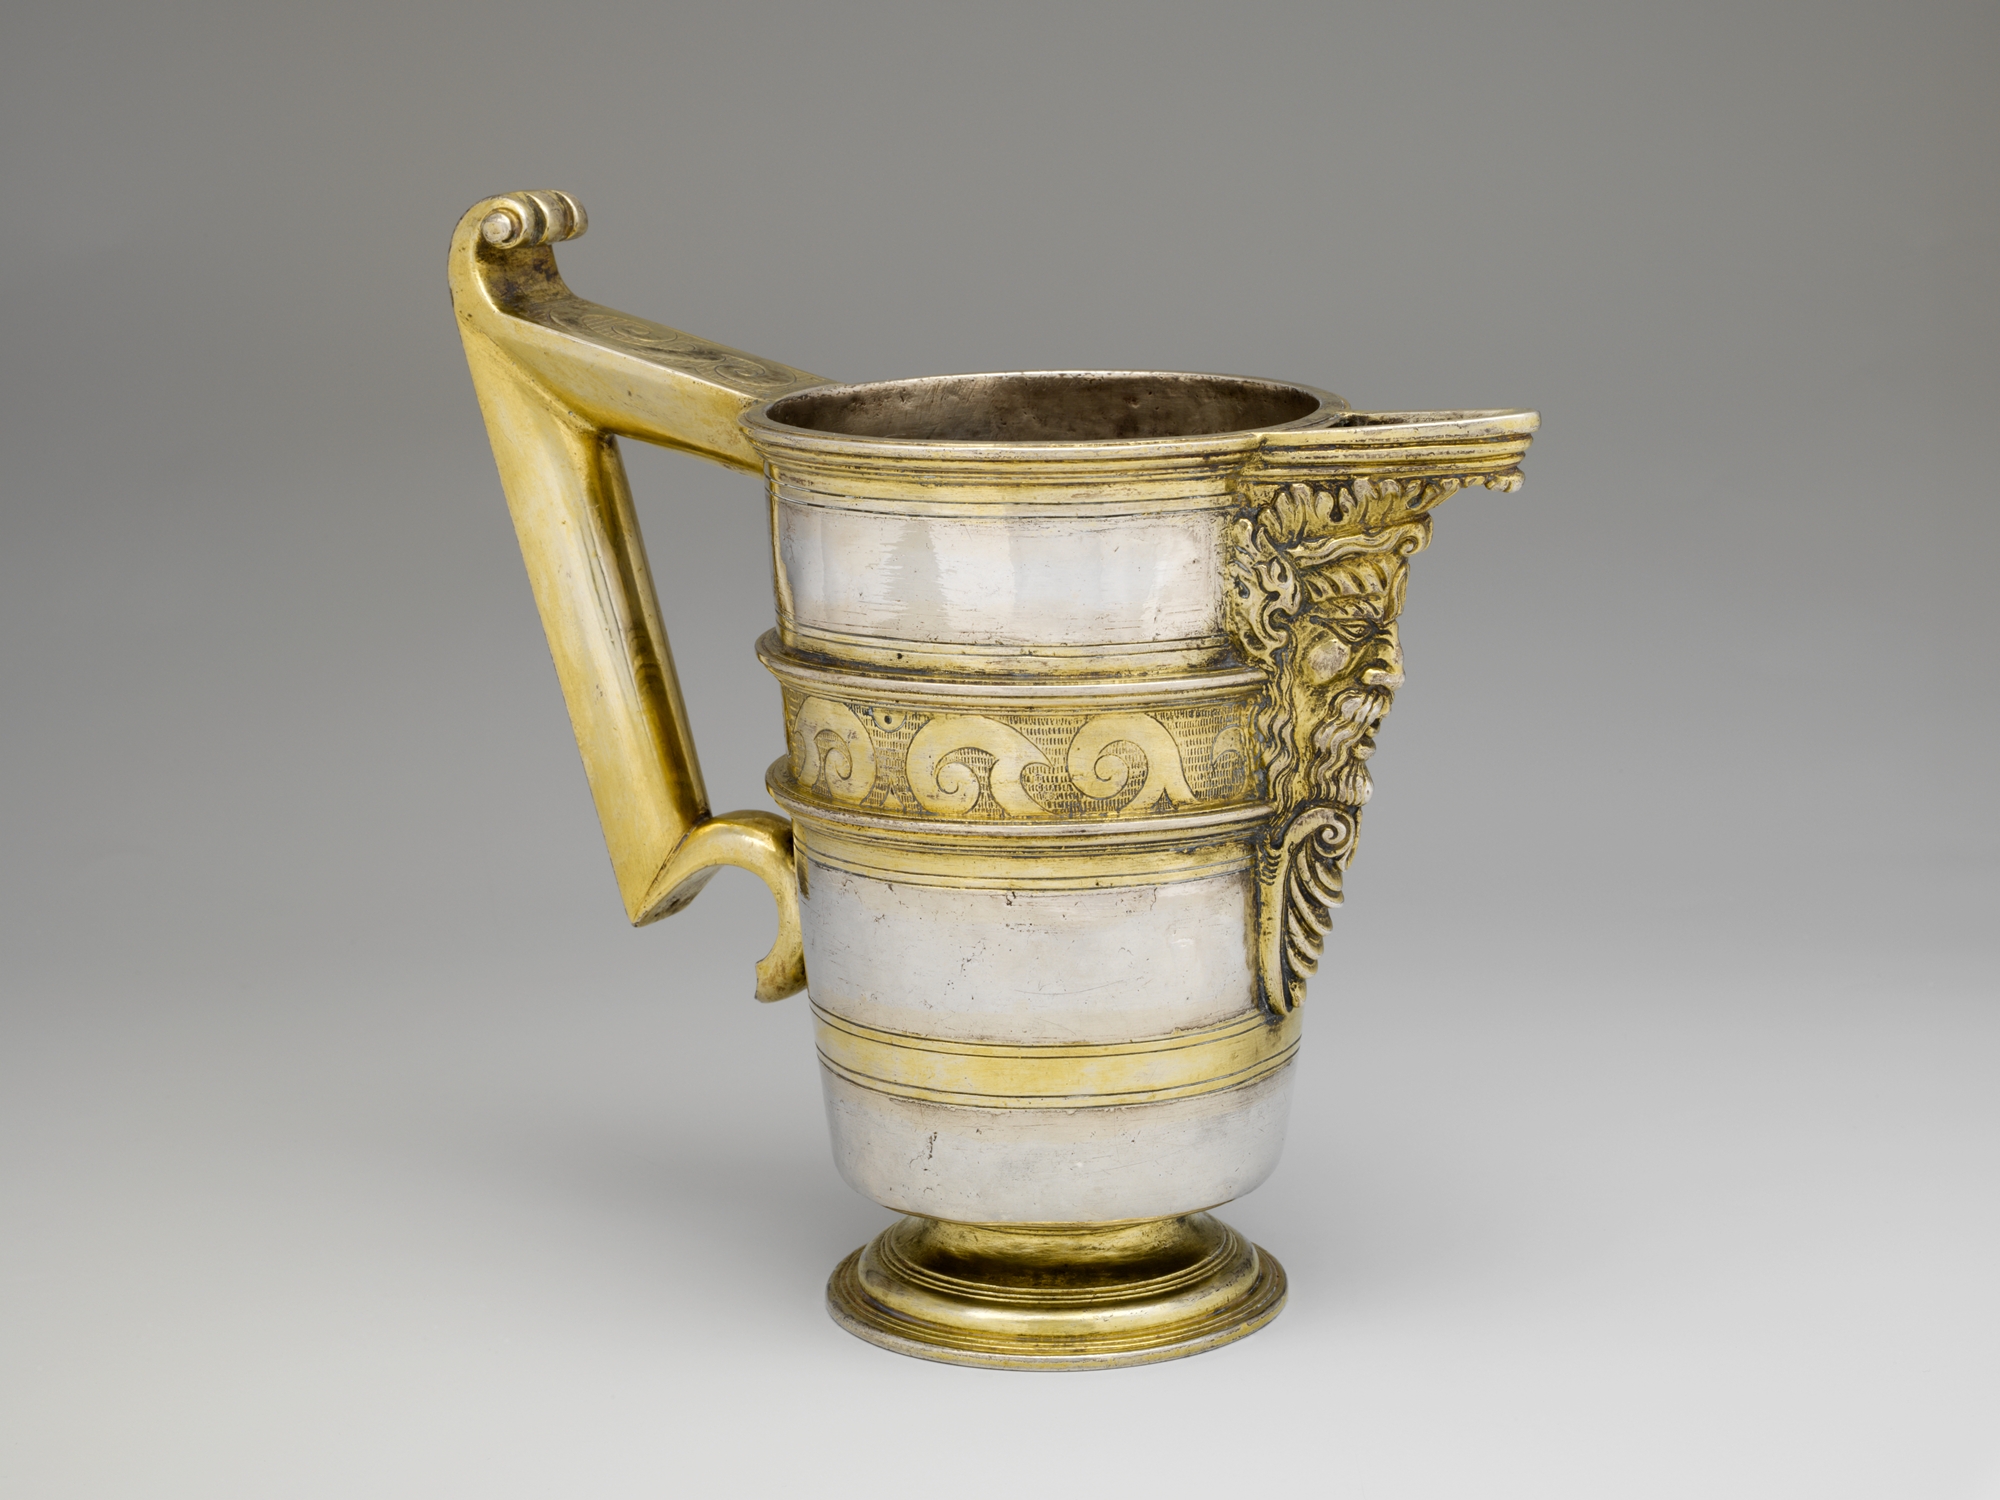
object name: ewer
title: Jarro de Pico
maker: hernando solis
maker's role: maker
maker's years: 1550-1650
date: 1567-1600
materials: gilt, silver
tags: profiles